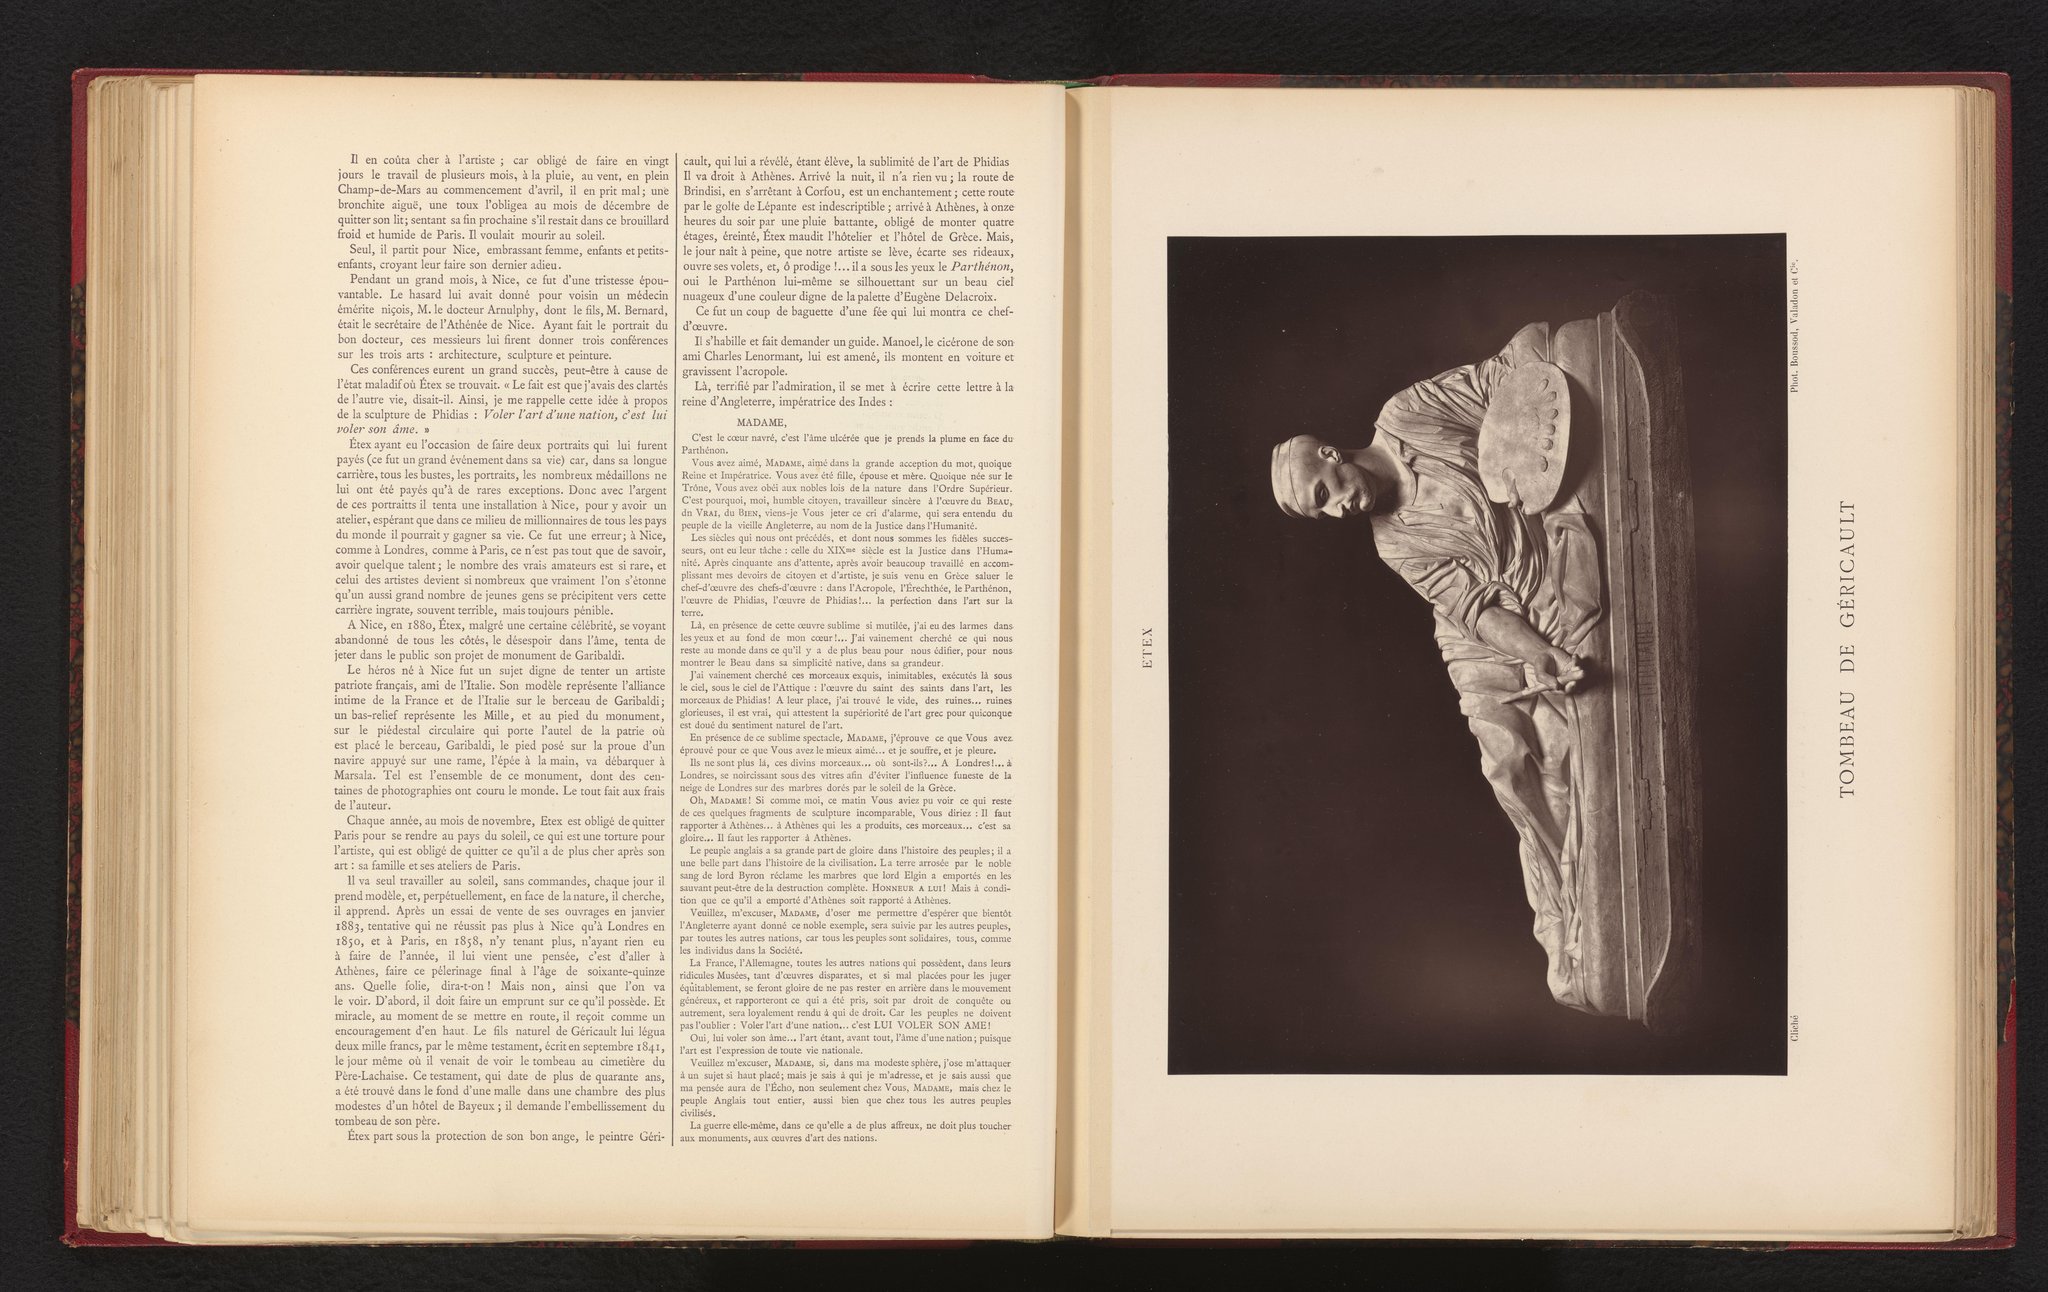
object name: photomechanical print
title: Tombeau de Géricault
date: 1879-1884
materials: paper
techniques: woodburytype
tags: paris, draughtsman, théodore géricault, grave, tomb